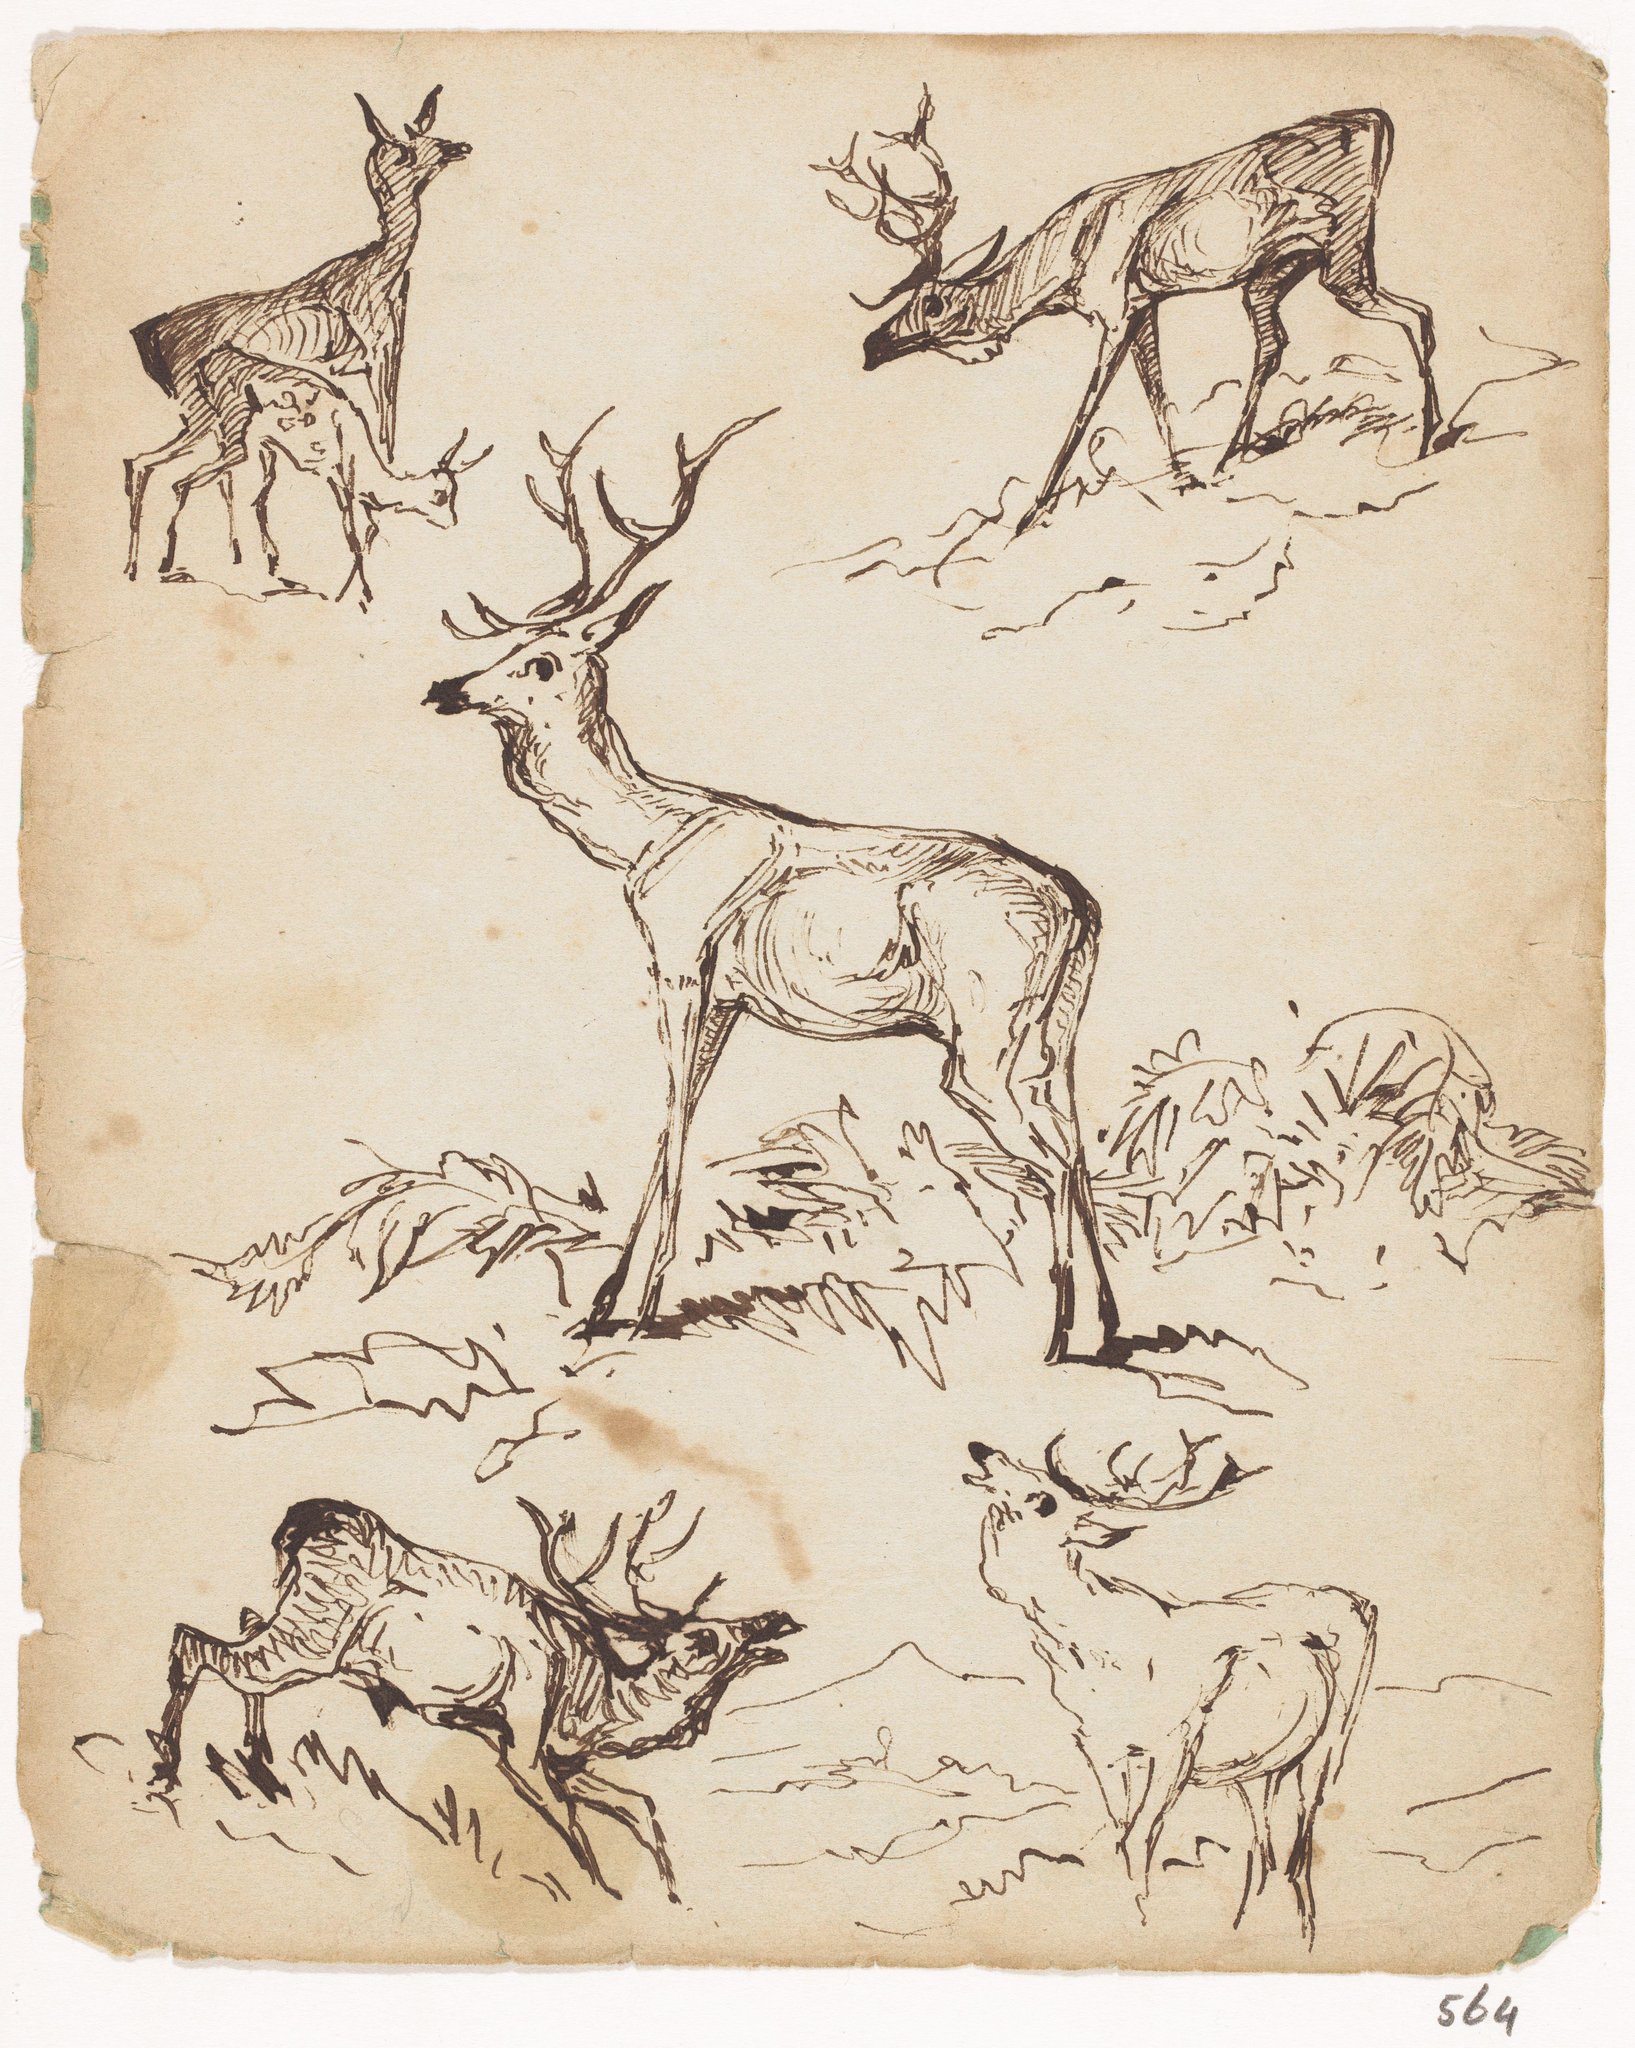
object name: drawing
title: Schetsblad met herten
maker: johannes tavenraat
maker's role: draughtsman, painter, print maker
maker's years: 1809-1881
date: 1840-1880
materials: ink, paper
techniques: pen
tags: hoofed animals: deer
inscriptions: collector's mark: Lugt 2228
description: Schetsblad met herten. Getekend op de achterzijde van een kinderprent 'Het paard van den Prins van Oranje bij Bautersem gekwetst. 11 Augustus 1831', van J. Schuitemaker te Purmerend.